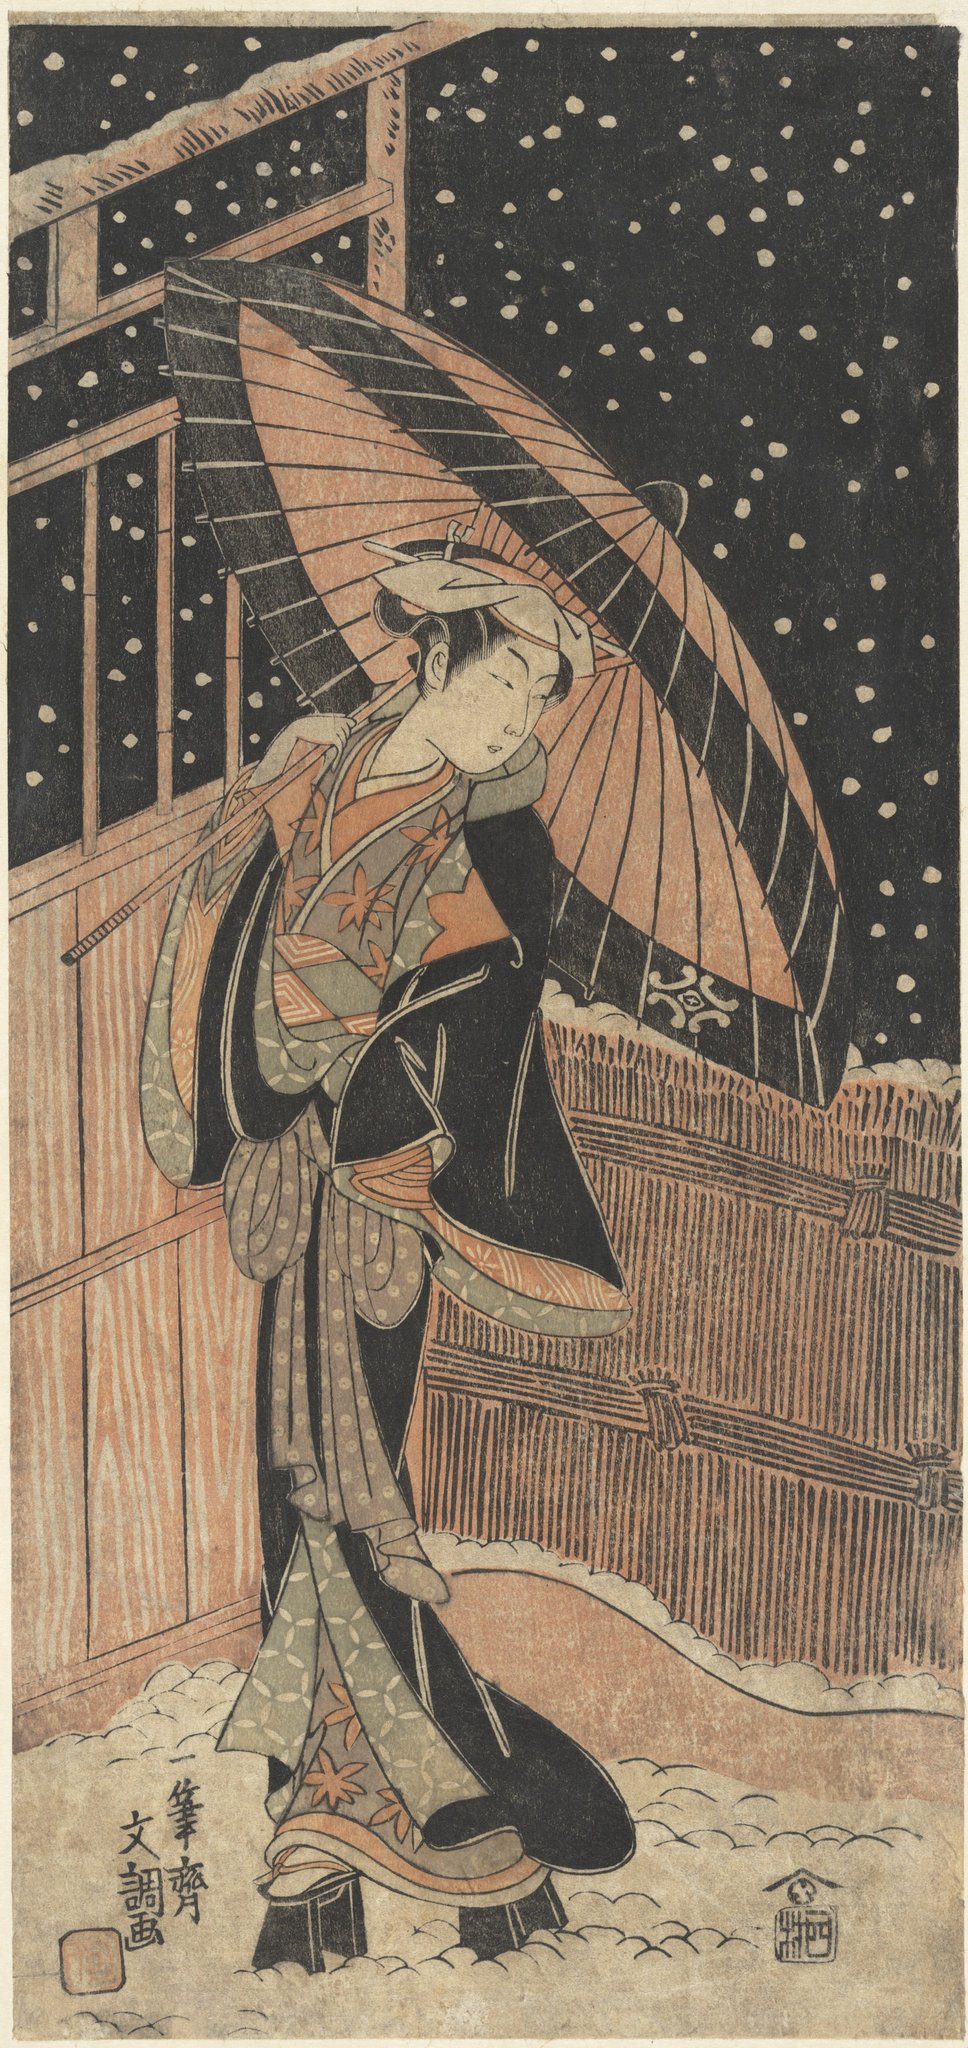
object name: print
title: The Actor Nakamura Kiyozo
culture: japanese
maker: ippitsusai bunchō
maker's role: artist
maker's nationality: japanese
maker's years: 1765-1792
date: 1769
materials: ink, paper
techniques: woodblock print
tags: women,snow,actors,umbrellas